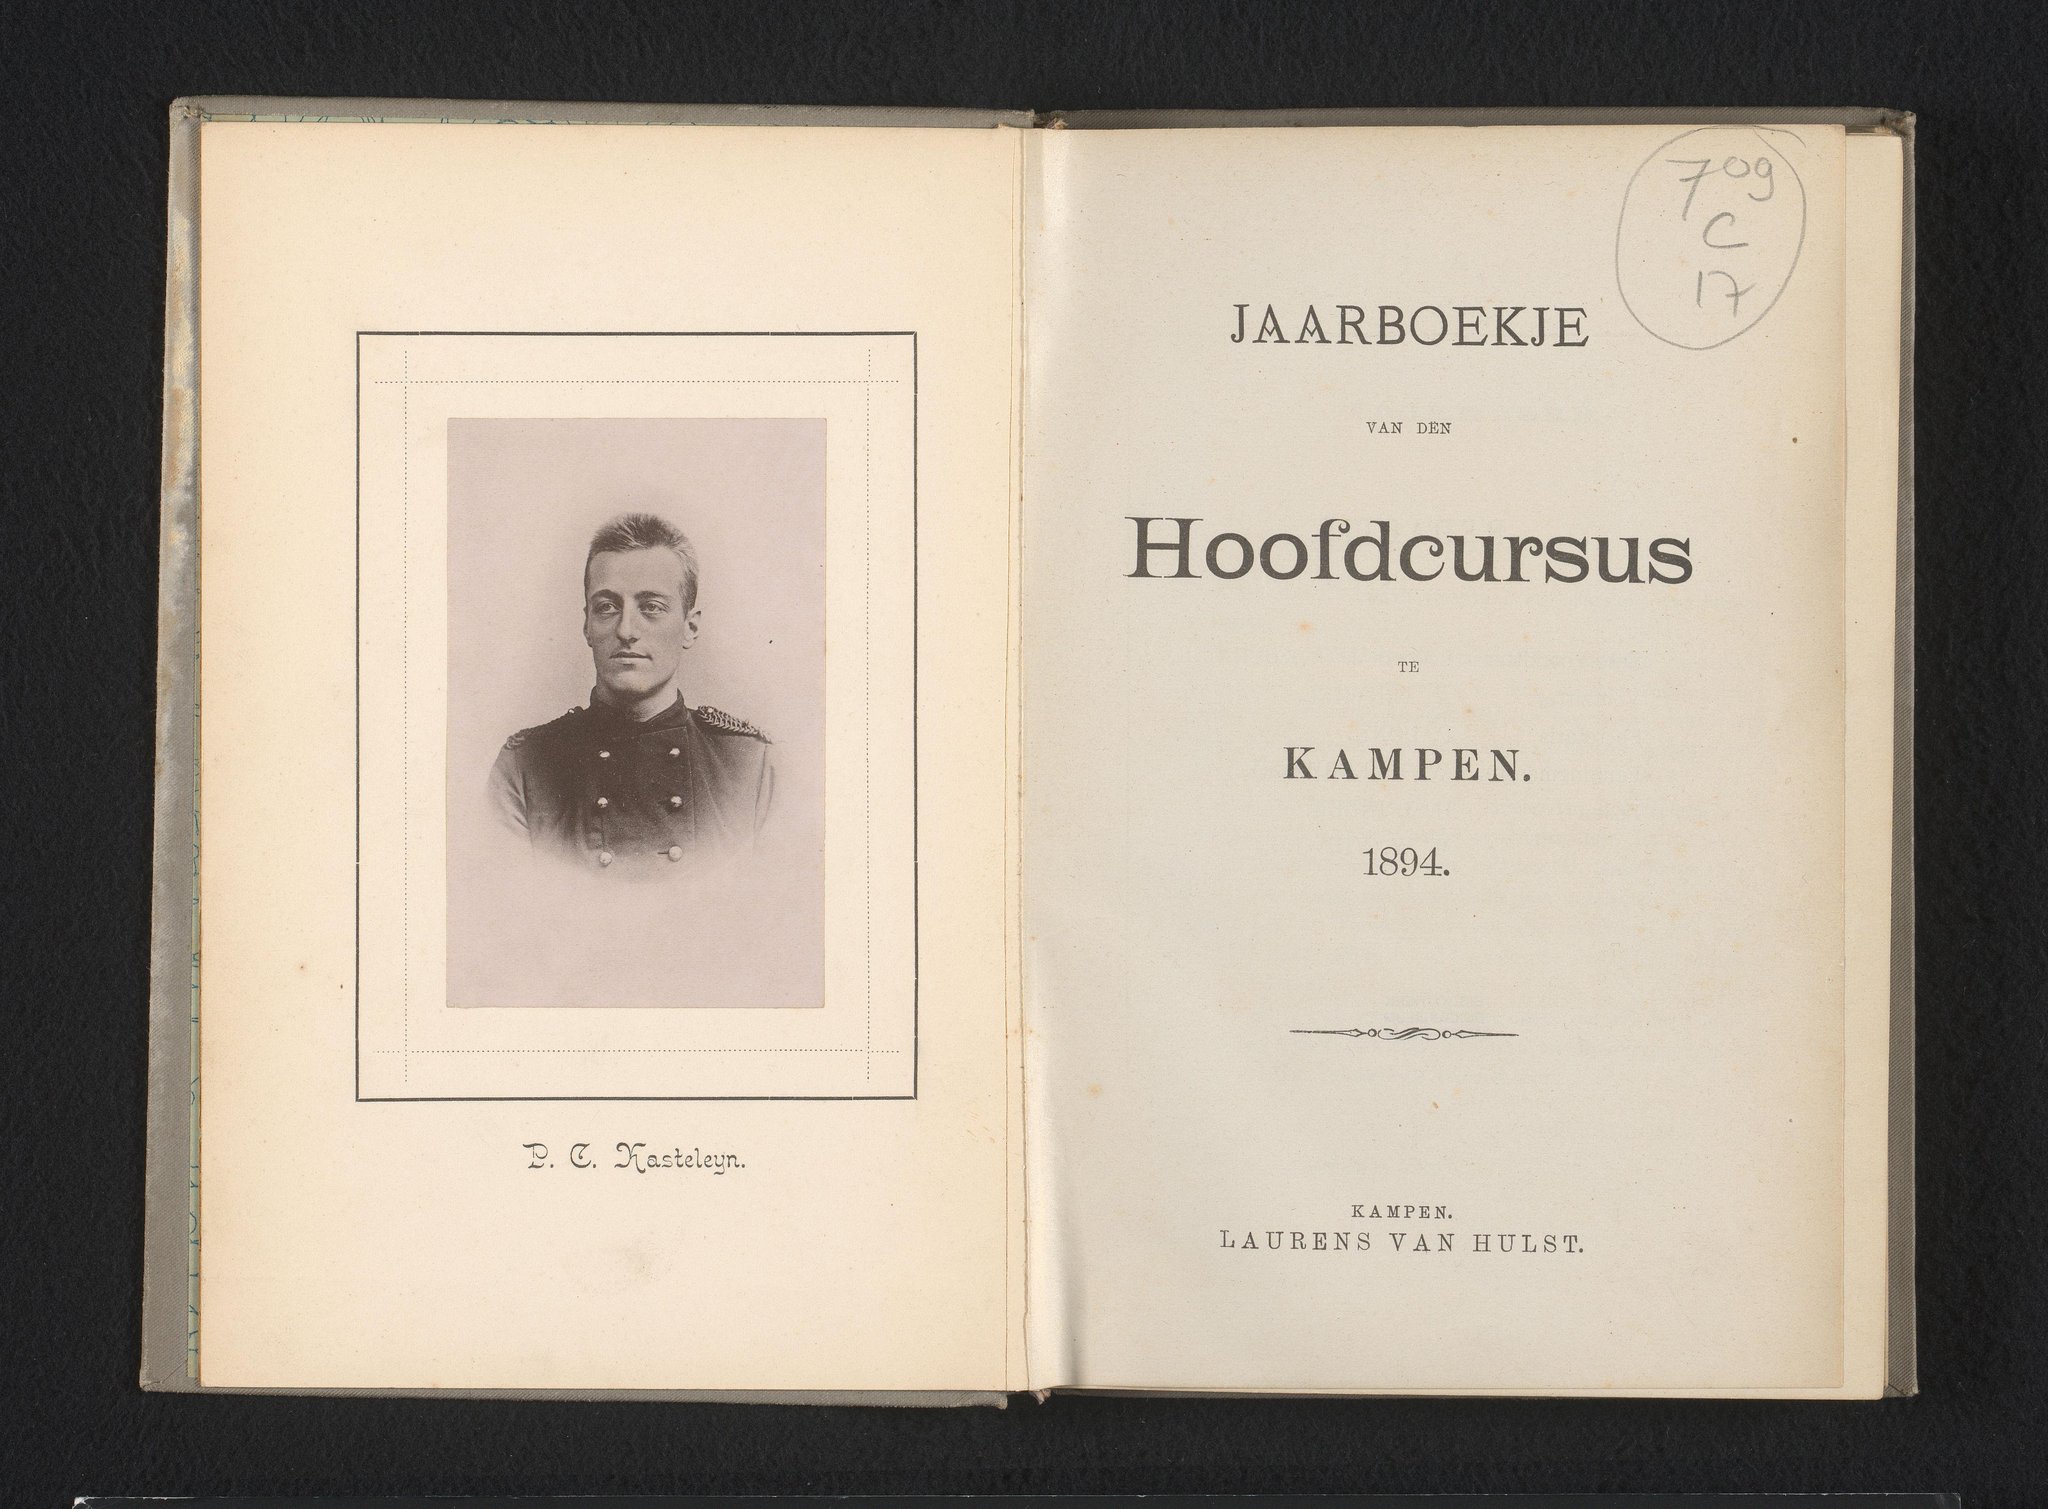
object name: page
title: Portret van Piet C. Kasteleyn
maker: Anonymous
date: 1889-1894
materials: paper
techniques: photograph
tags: historical persons